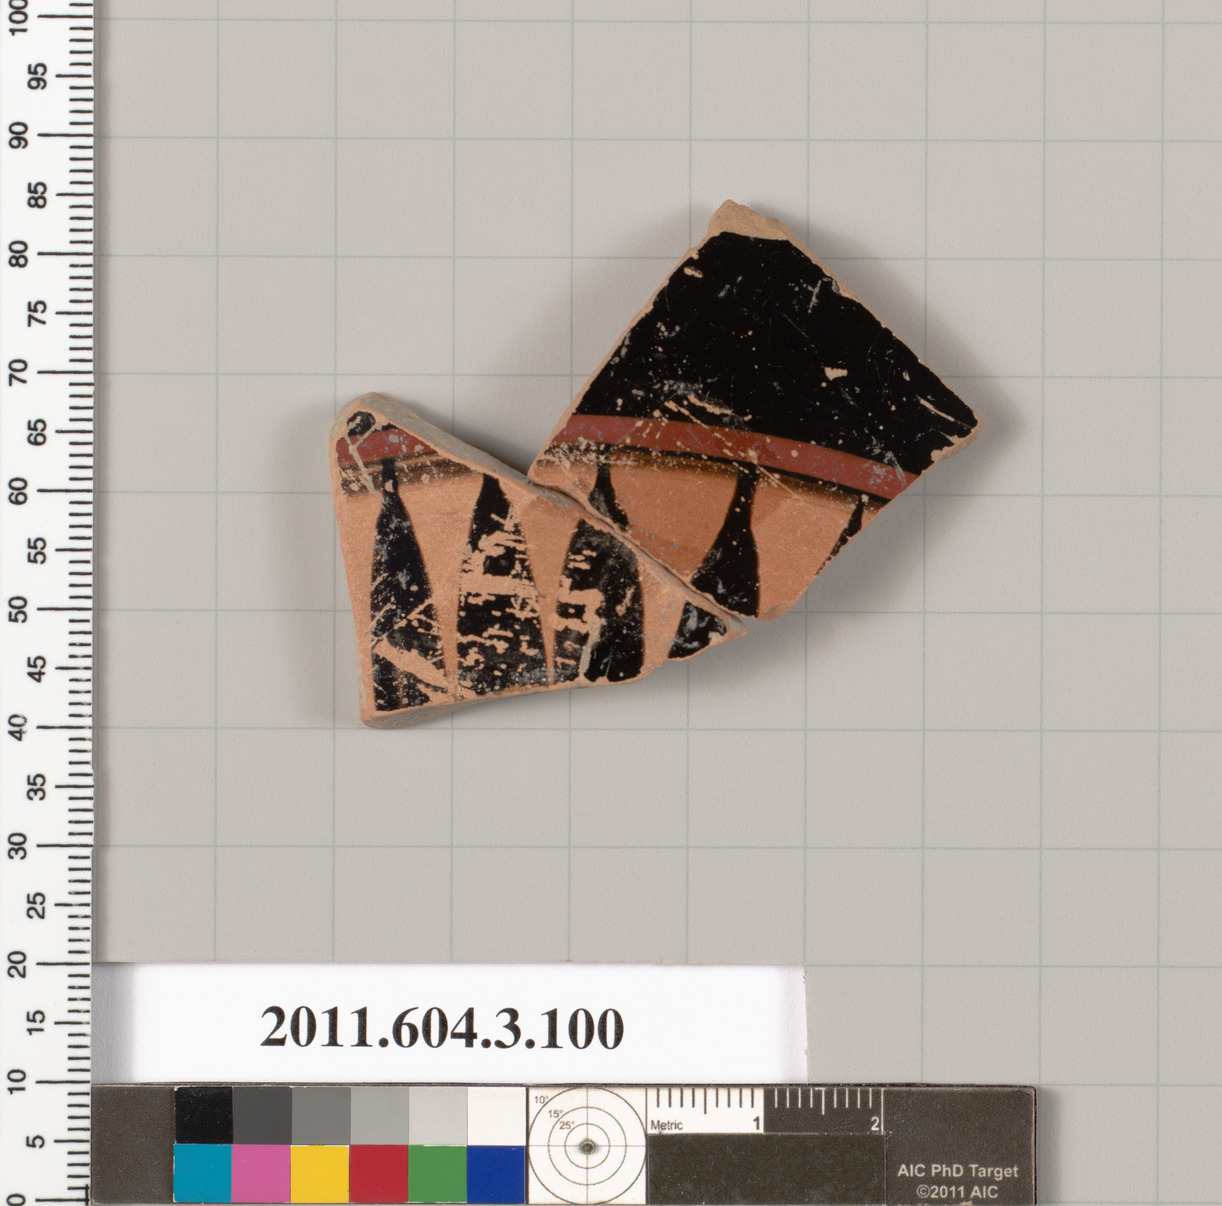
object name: amphora fragment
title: Terracotta fragment of an amphora (jar)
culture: greek, attic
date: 600-468 BCE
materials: terracotta